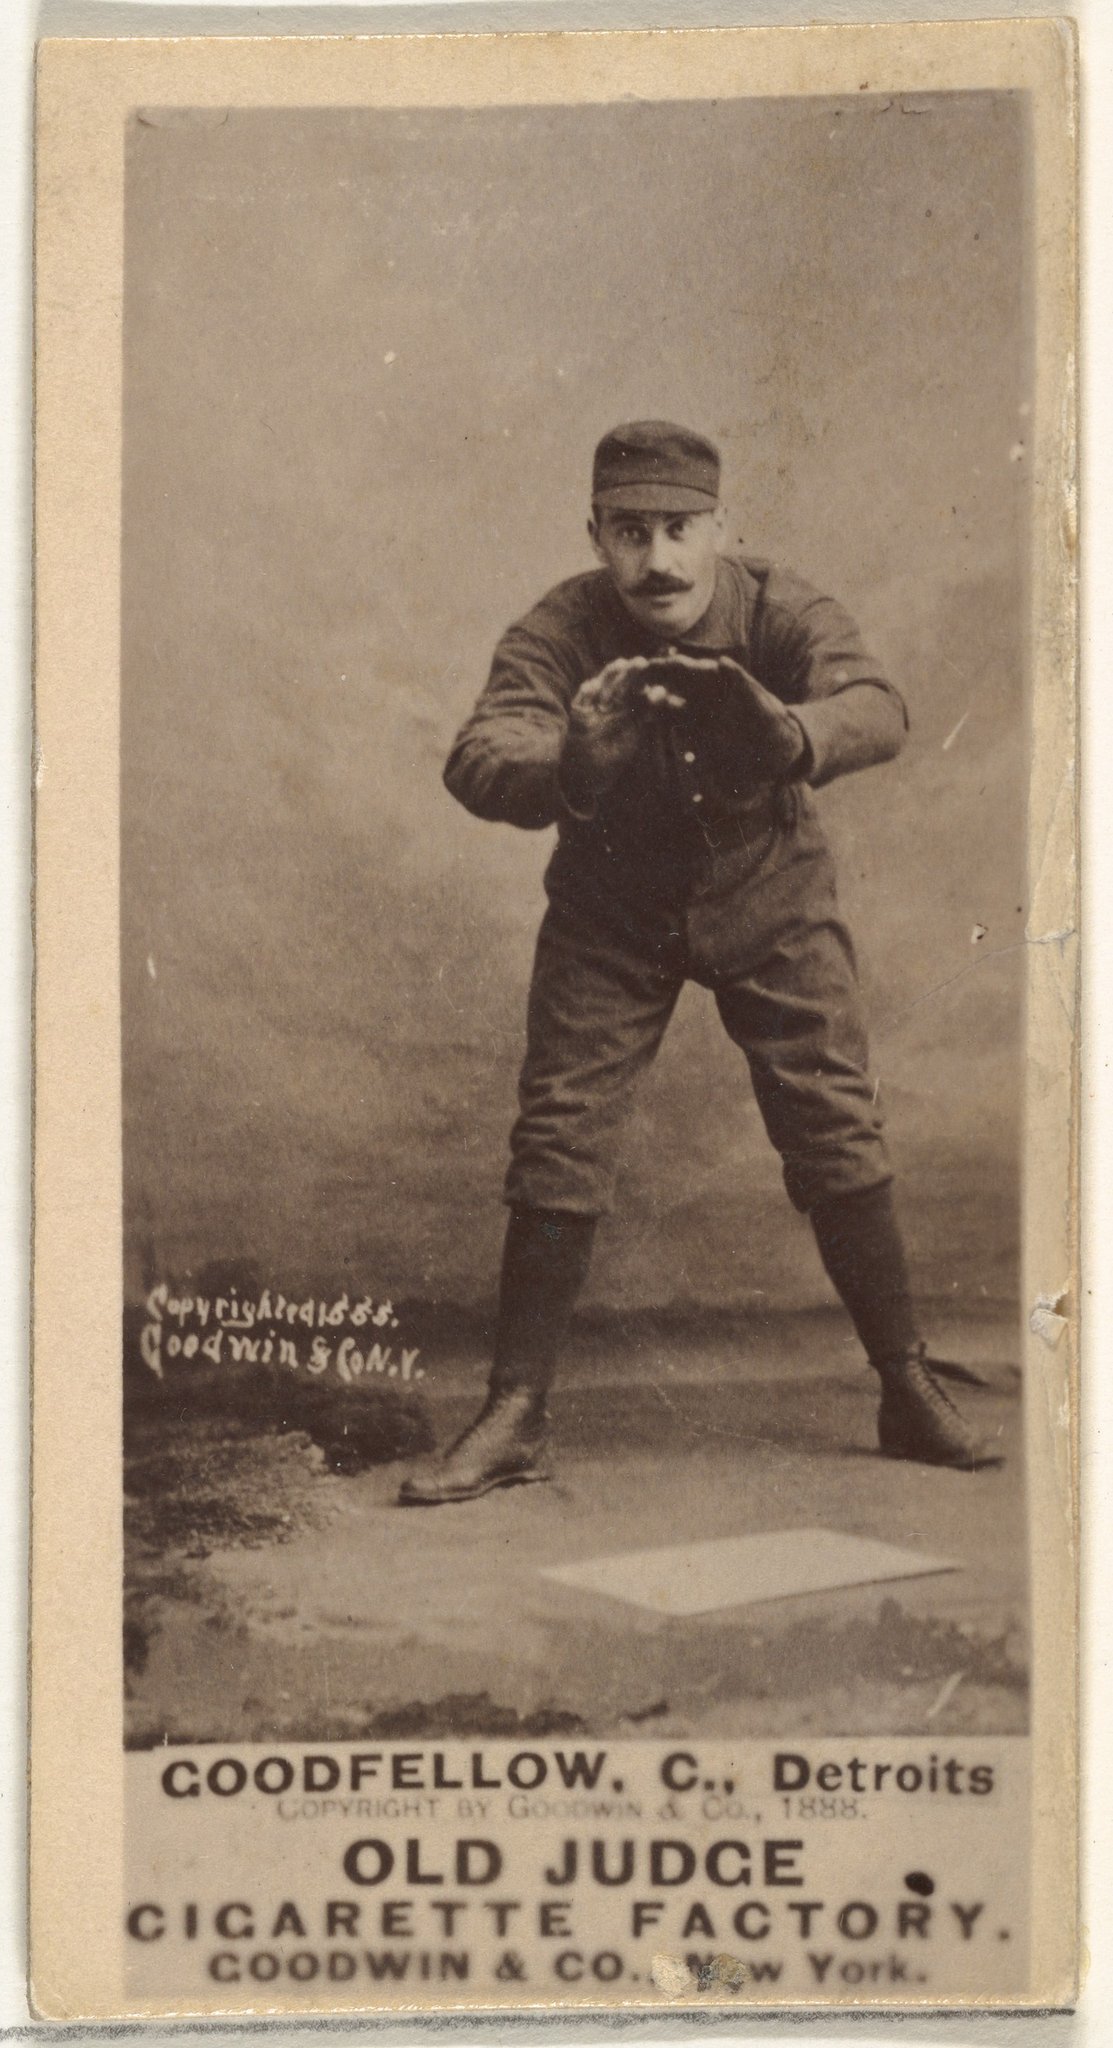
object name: baseball card, photograph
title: Goodfellow, Catcher, Detroit Wolverines, from the Old Judge series (N172) for Old Judge Cigarettes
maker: goodwin & company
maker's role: publisher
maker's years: 1850-1950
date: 1888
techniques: albumen silver print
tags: men,portraits,baseball,athletes